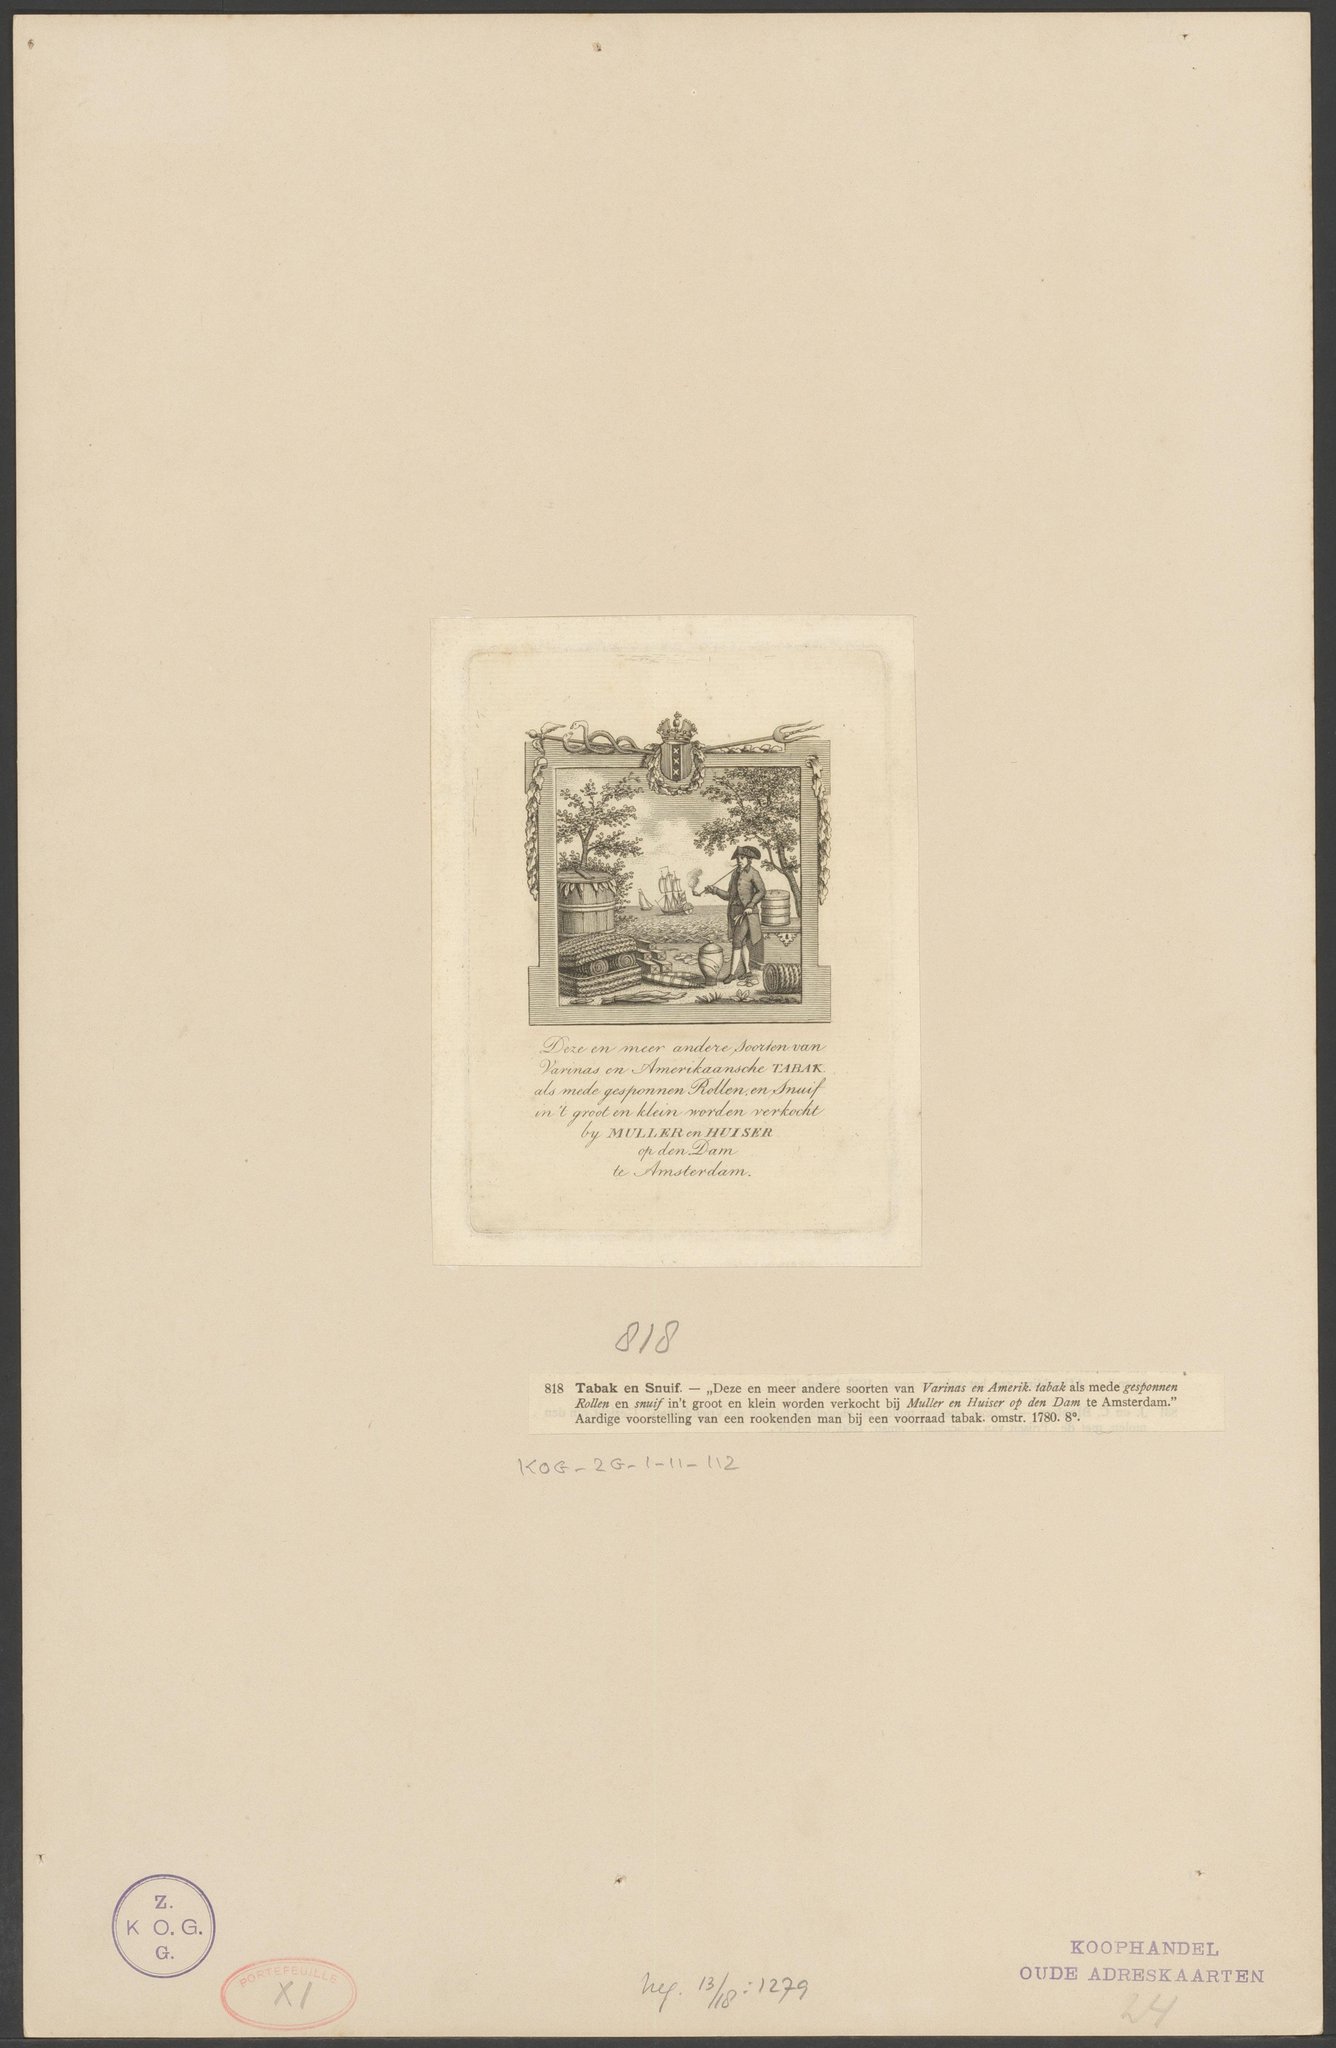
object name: print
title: Handelsetiket van Muller en Huiser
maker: Anonymous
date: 1780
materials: paper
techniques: engraving, etching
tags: ships (in general), tobacco, amsterdam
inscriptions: collector's mark: Lugt 1641, stamp, stamp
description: Handelsetiket van Muller en Huiser. Muller en Huiser handelen in tabak in verschillende vormen, zoals snuiftabak, gesponnen tabak en tabak rollen. De winkel bevond zich op de Dam in Amsterdam. Het handelsetiket bestaat uit een gezicht op zee met een wegvarend schip. Op de kade staat een rokende man. Er omheen een lijst met het wapen van Amsterdam met een caduceus en een drietand. Onderwerpsrubrieken binnen de Atlas Zeden en Gewoonten: Handel, nijverheid en verkeer, Koophandel, Veilingen, Makelaardij en Verzekeringswezen, Oude adreskaarten van winkels en fabrieken, reclame.